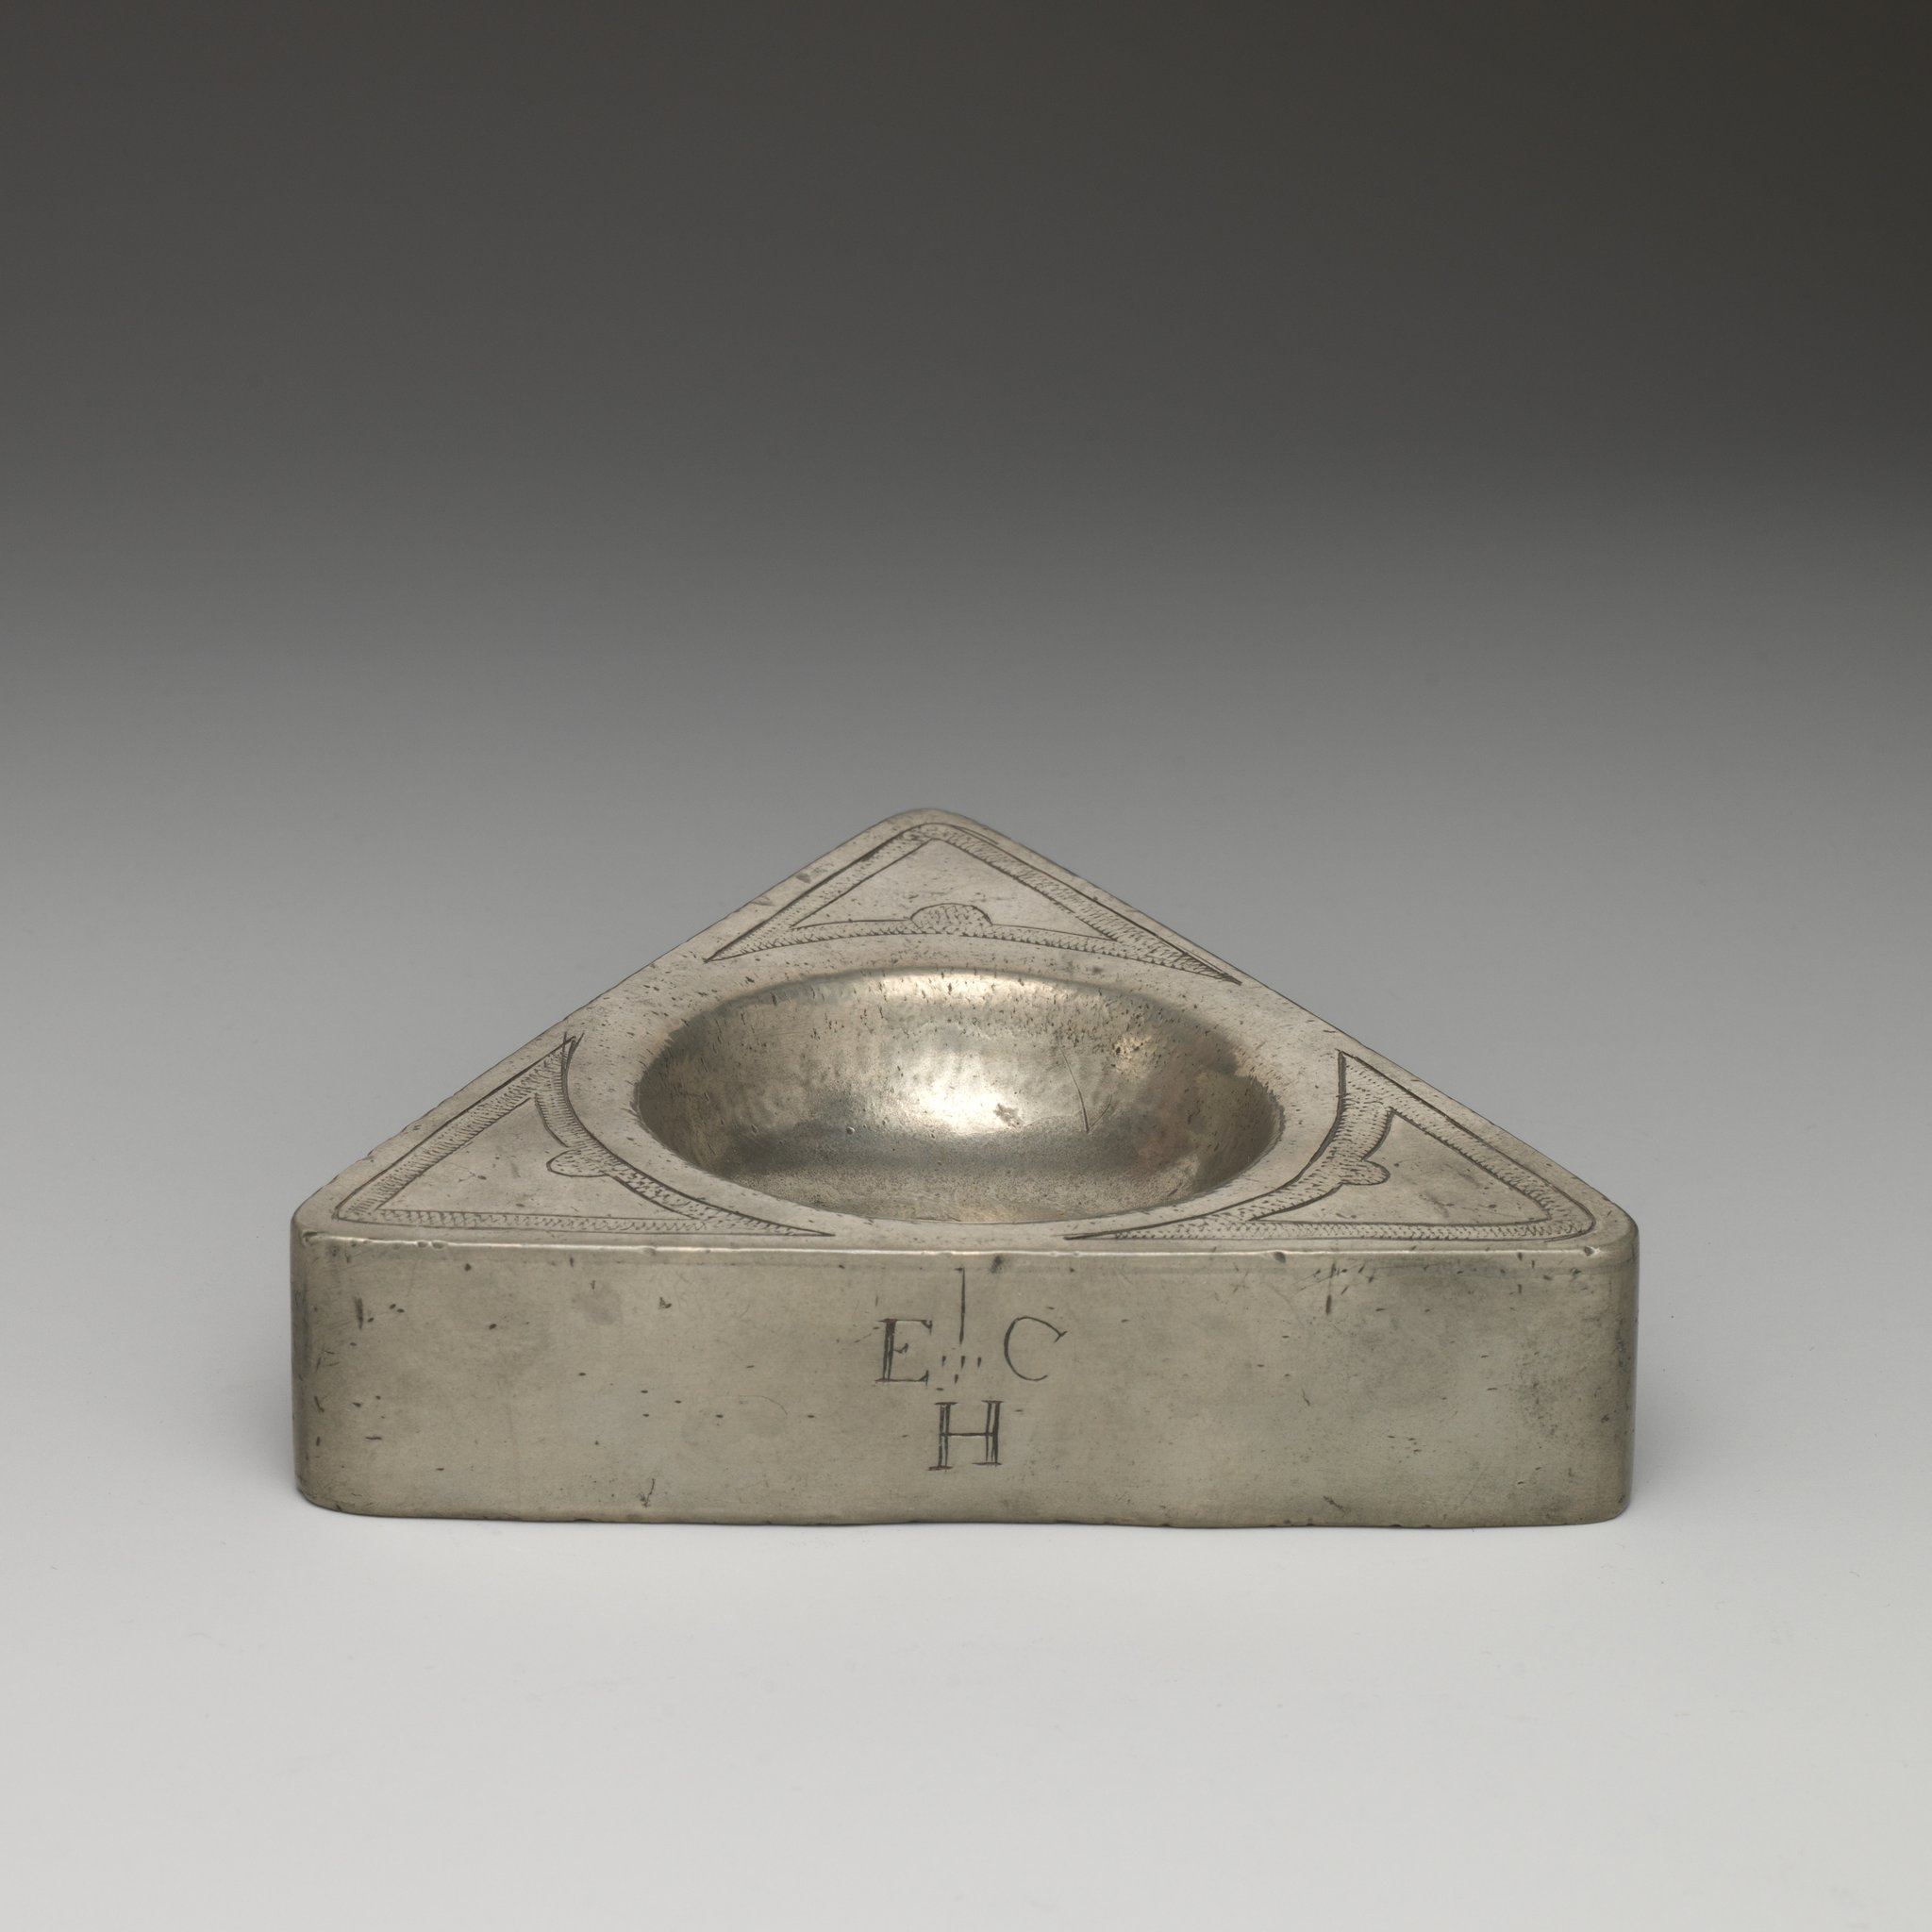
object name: salt trencher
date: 1820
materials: pewter